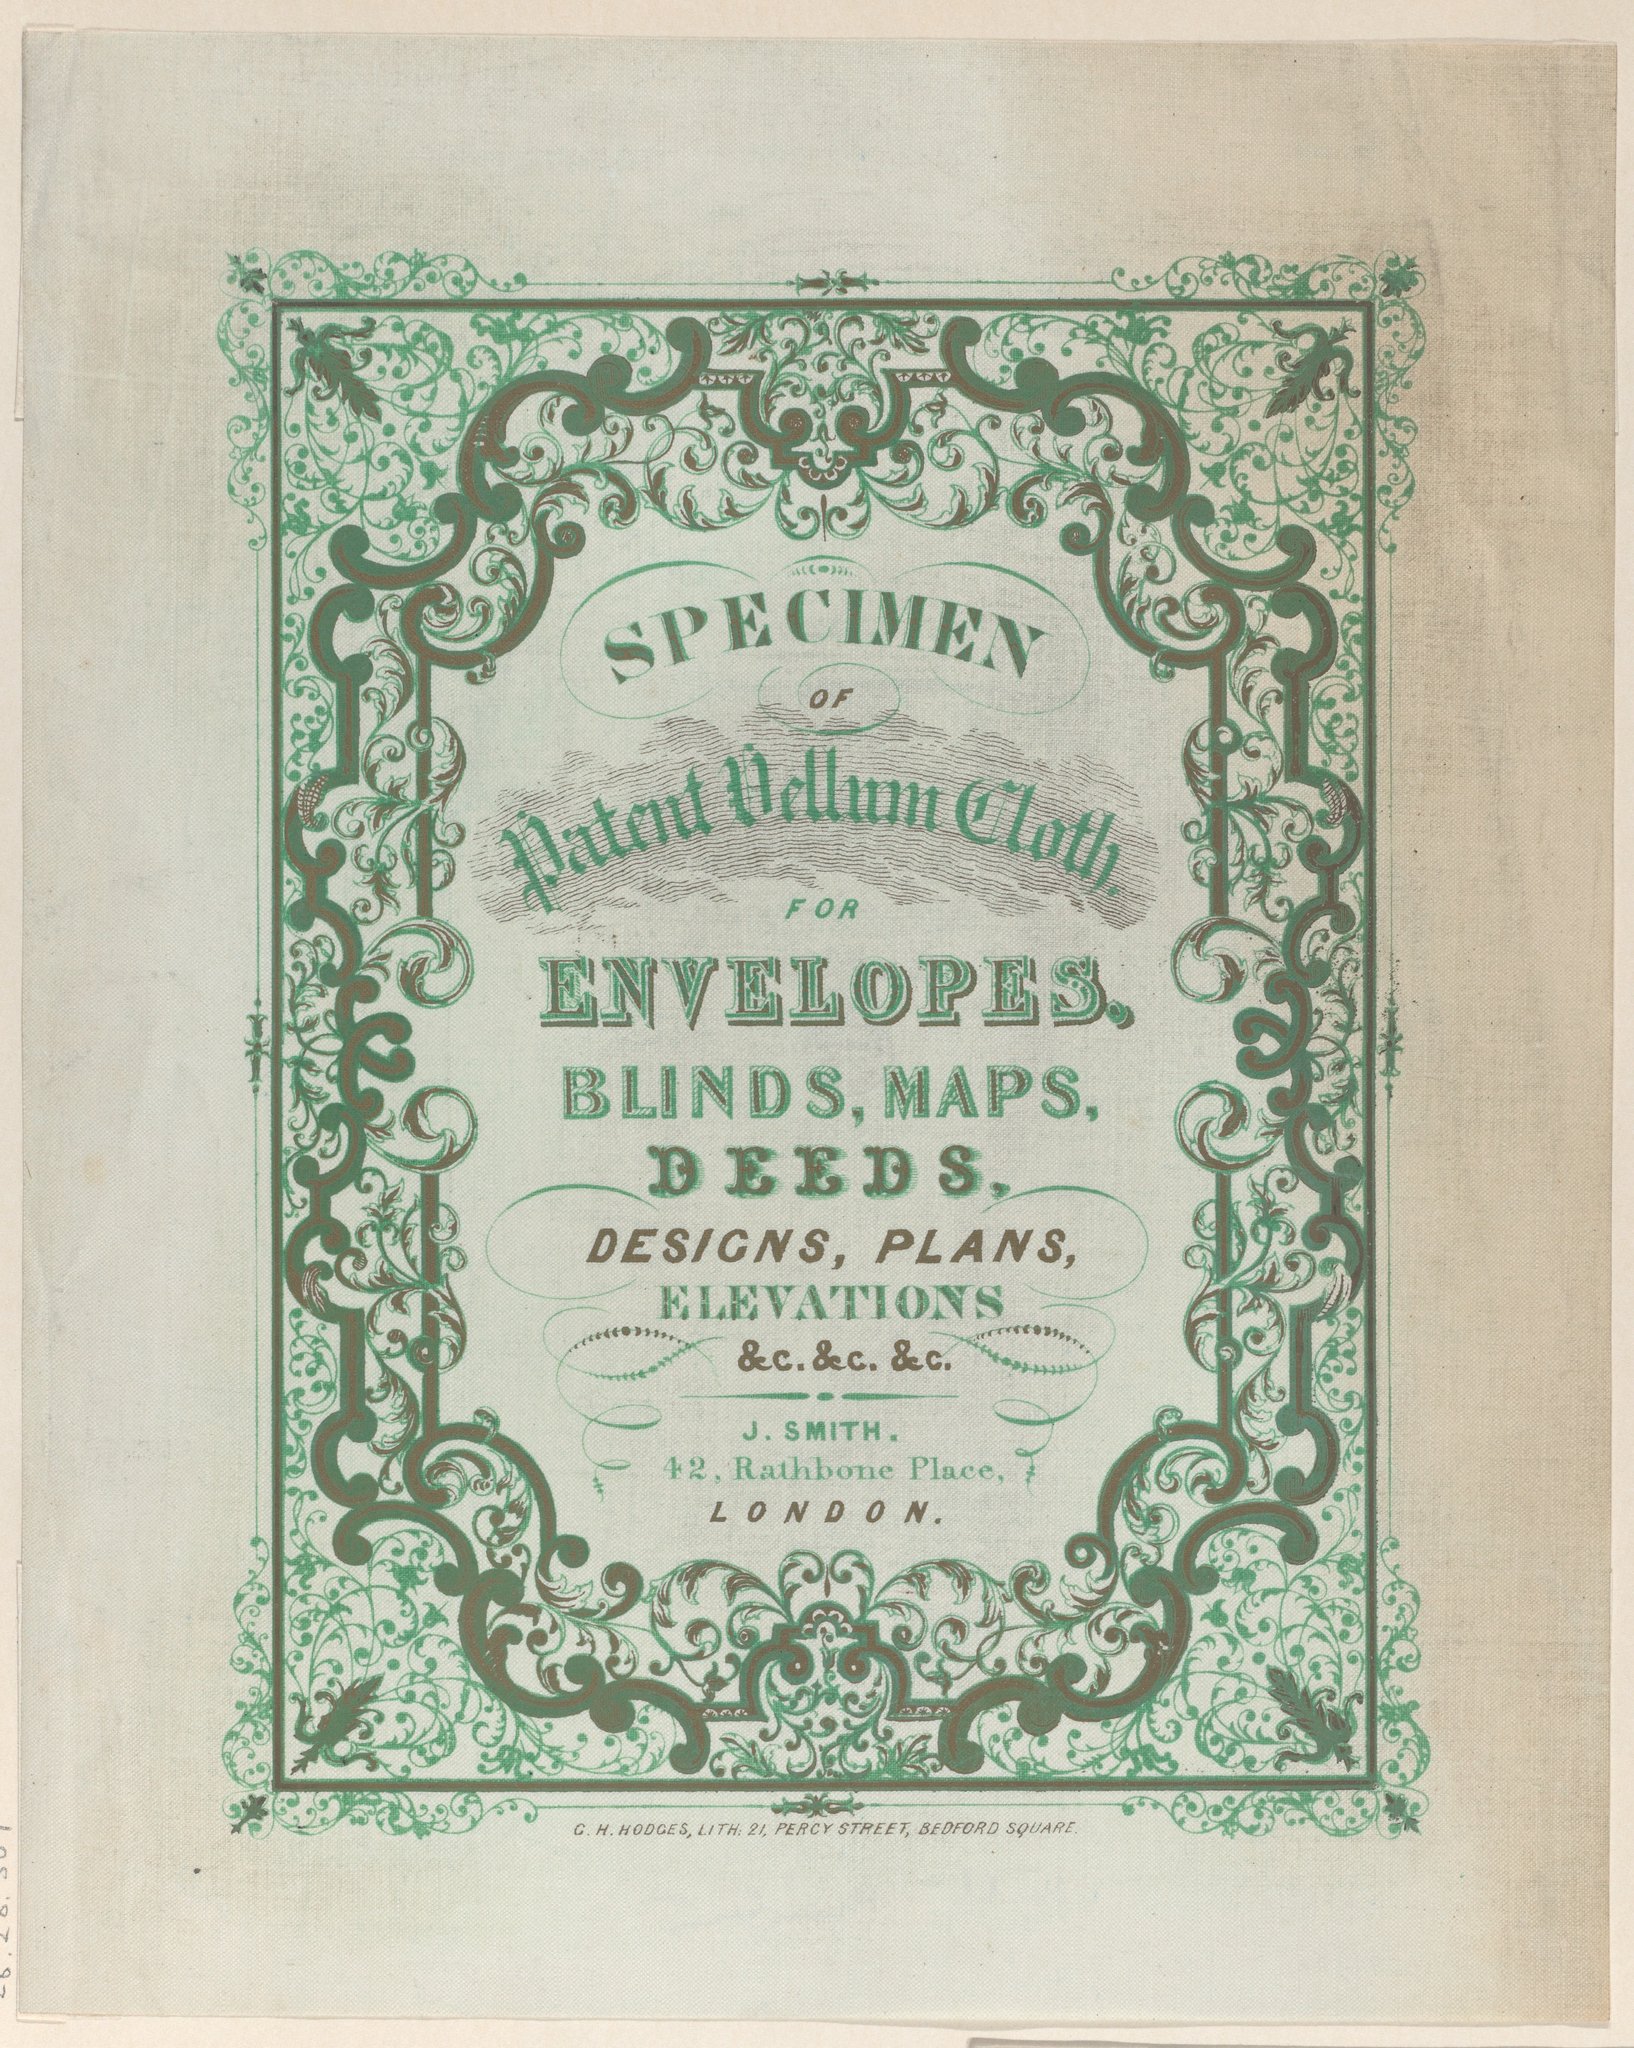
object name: print, trade card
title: Trade Card for J. Smith, Printer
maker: anonymous, british, 19th century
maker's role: artist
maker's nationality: british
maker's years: 1800-1900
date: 1801-1900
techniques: lithography